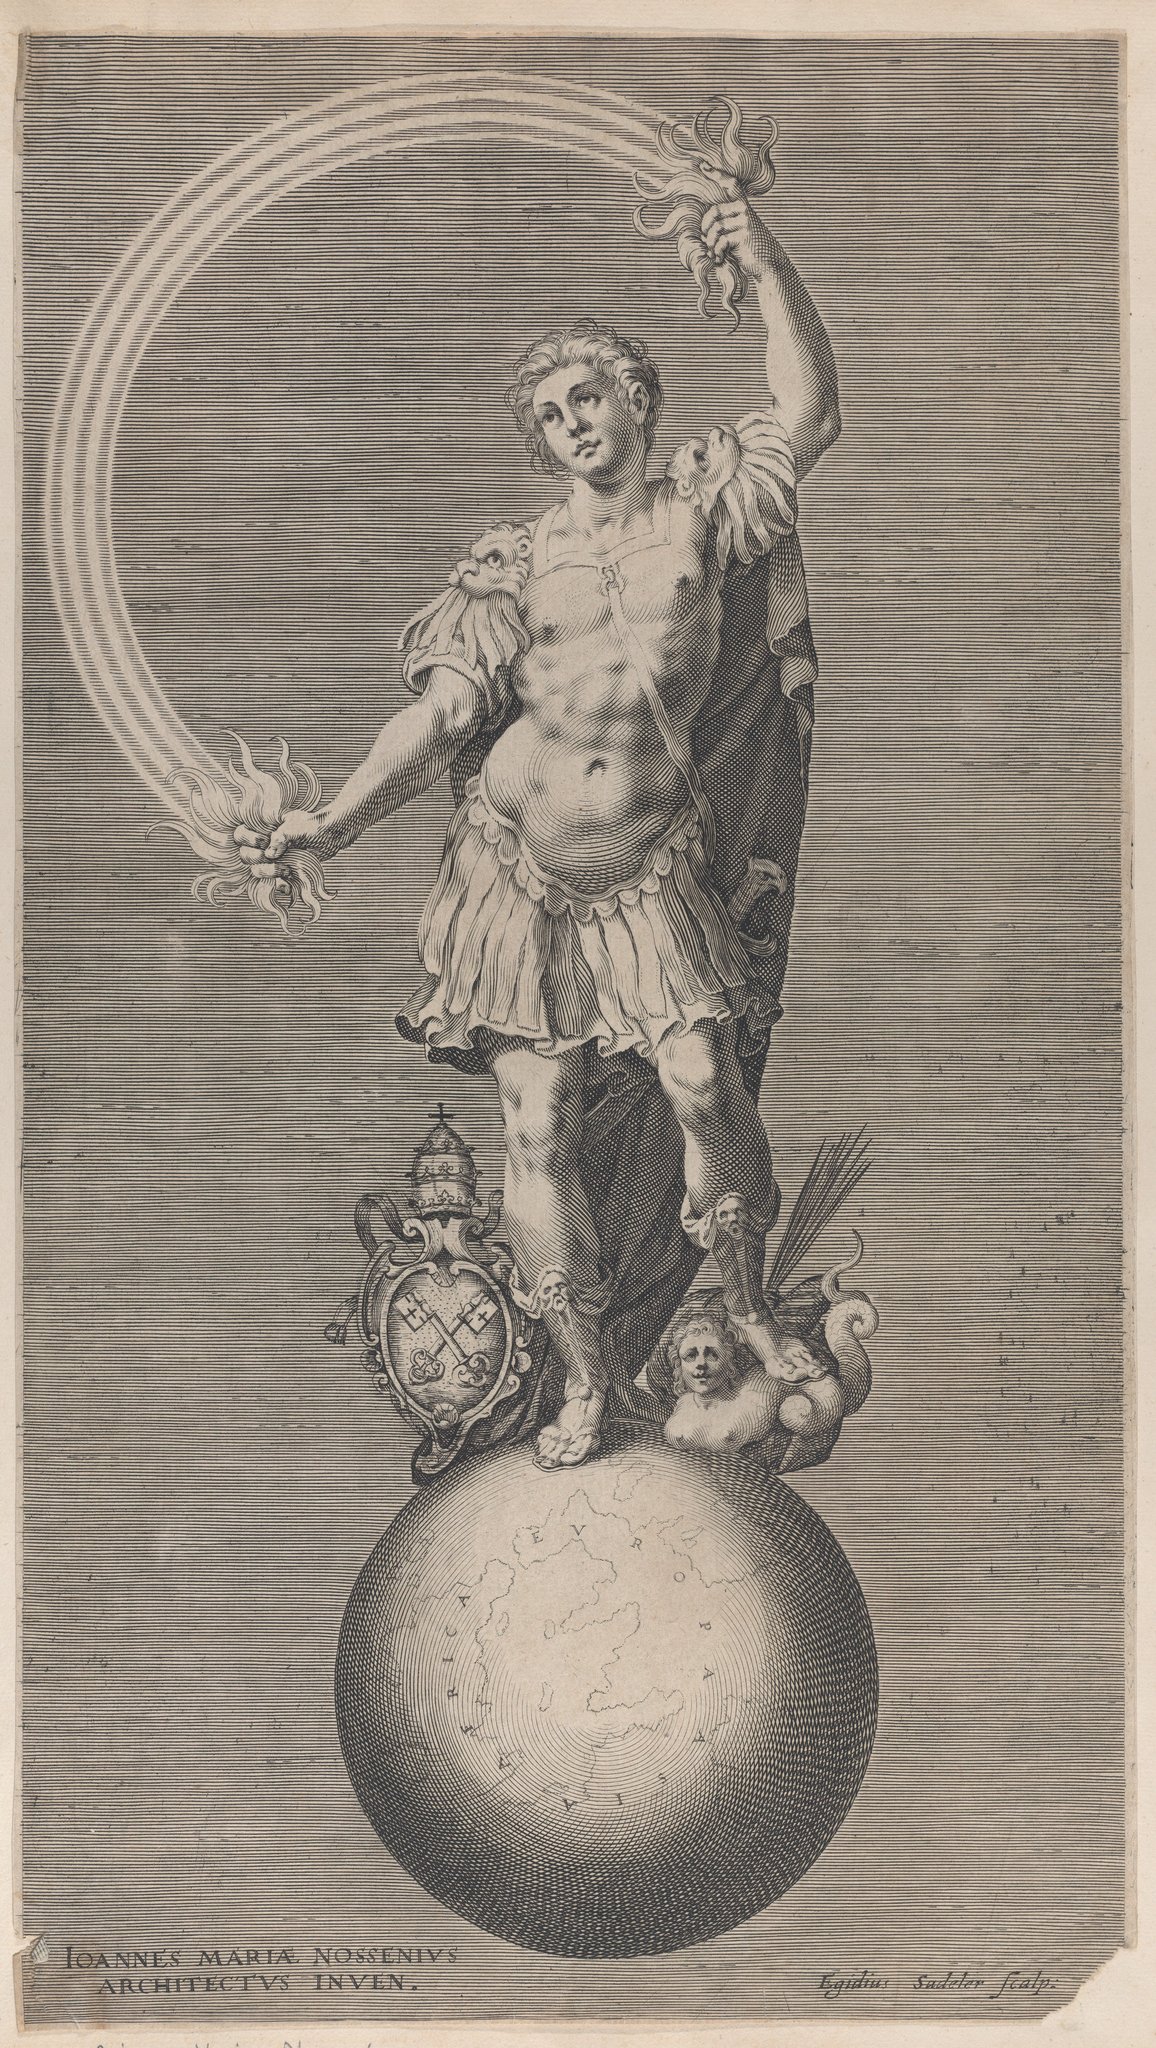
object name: print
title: Allegorical figure of a warrior standing on a globe with the papal coat of arms at his feet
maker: aegidius sadeler (ii)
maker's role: artist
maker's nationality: flemish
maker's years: 1568-1629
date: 1588-1629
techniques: engraving